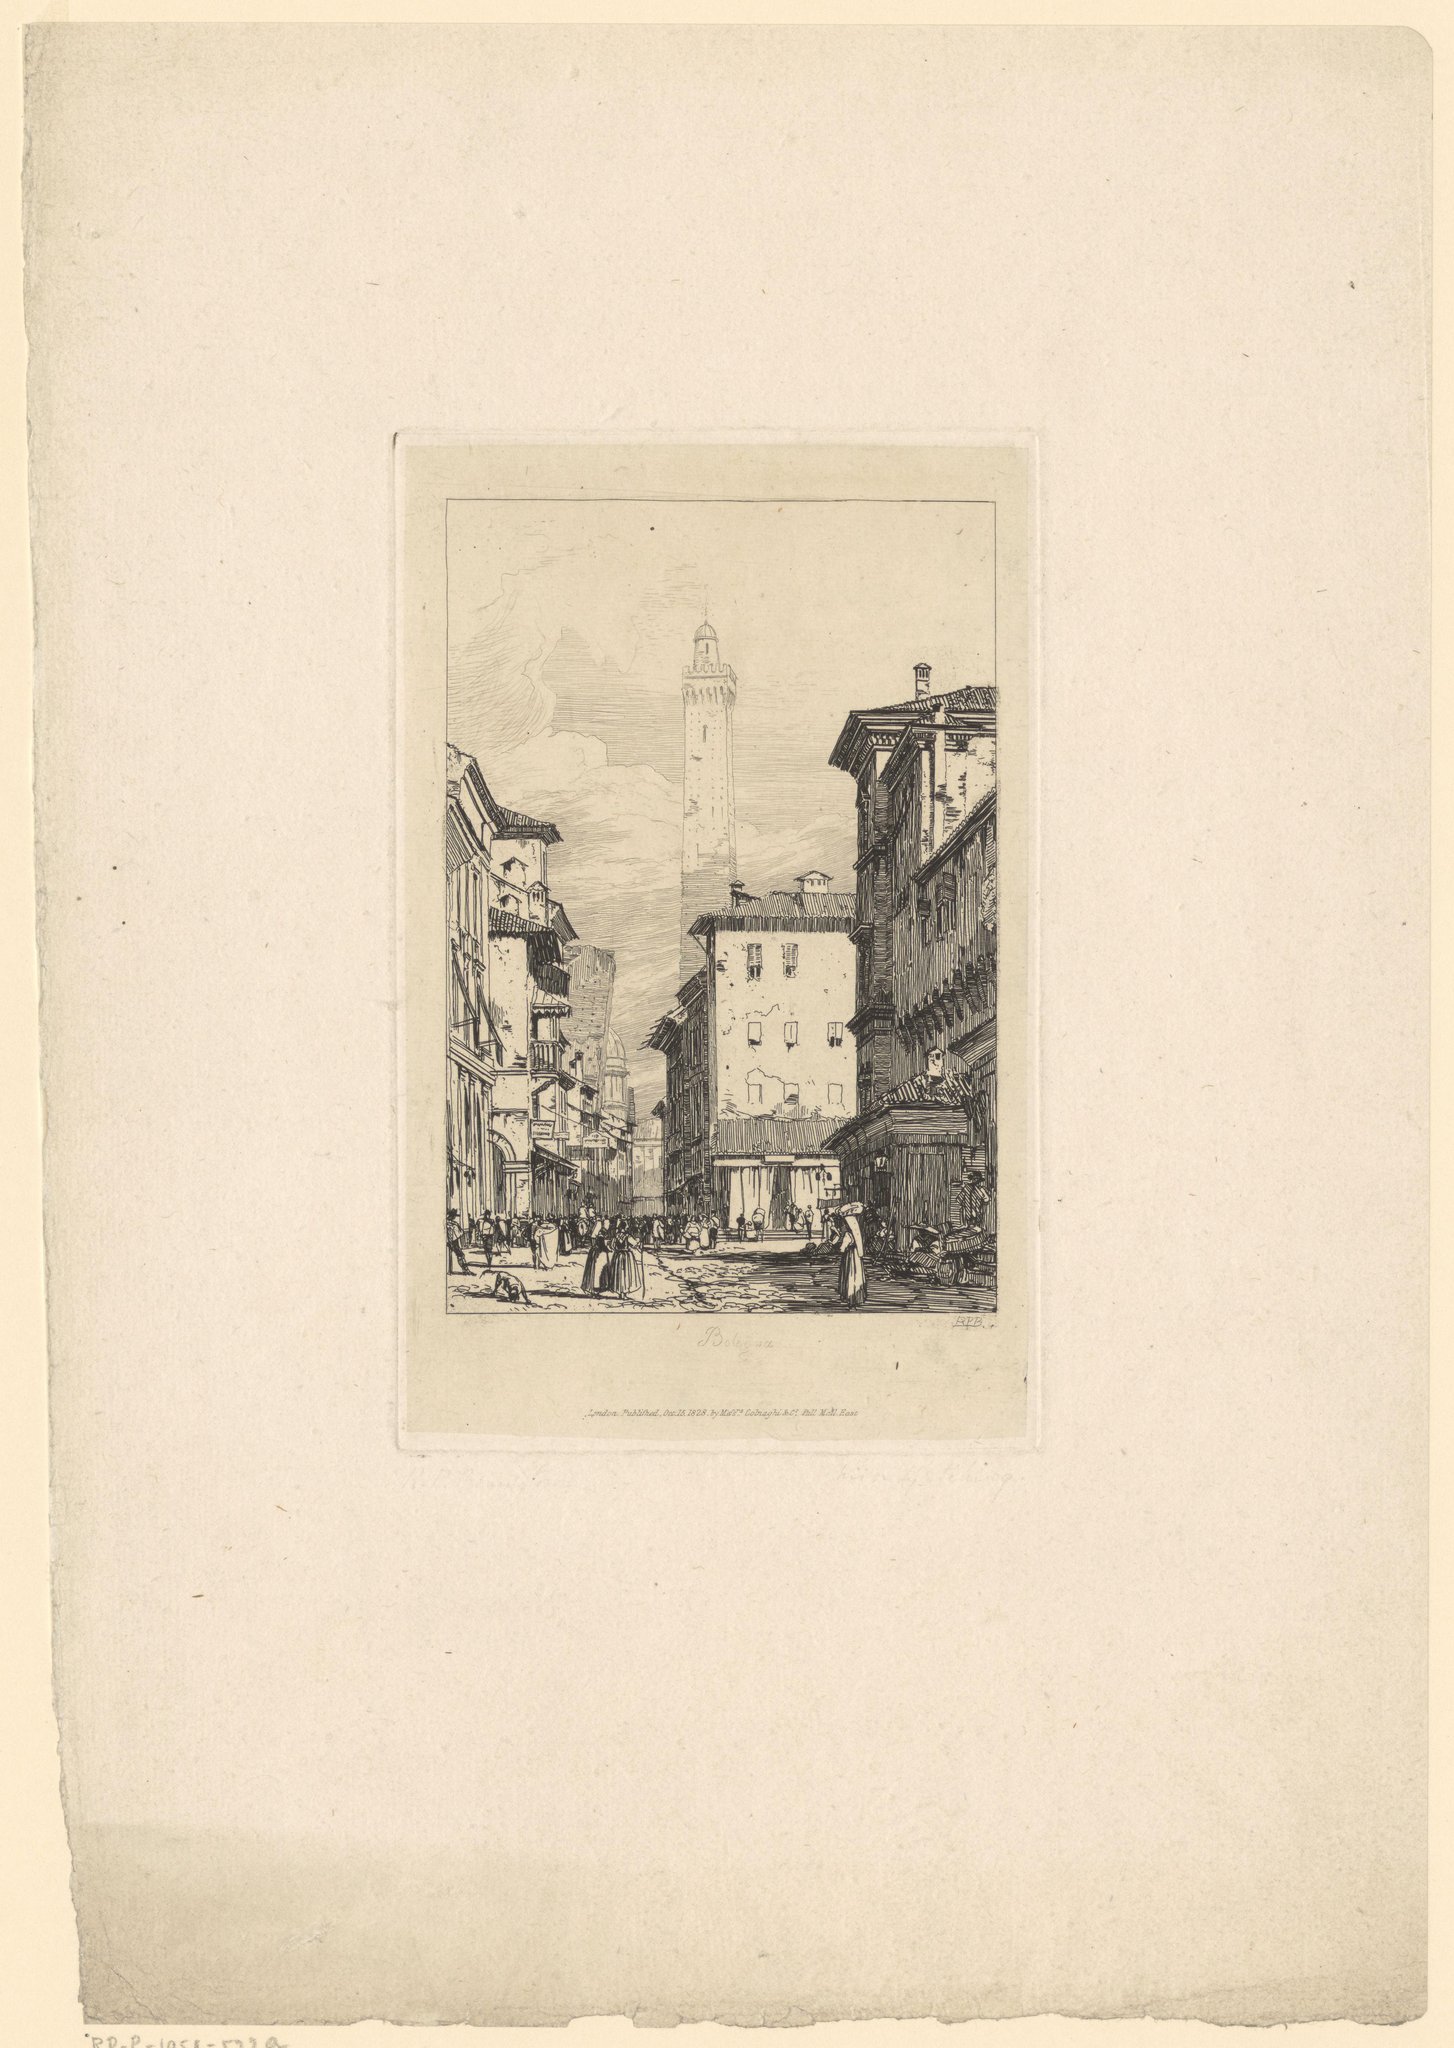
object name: print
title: Bologna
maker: richard parkes bonington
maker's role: painter, print maker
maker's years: 1801-1828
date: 1810-1828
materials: paper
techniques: etching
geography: london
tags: tower, clock tower ~ monumental adornment, street (+ city(-scape) with figures, staffage)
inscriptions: collector's mark: Lugt 2760, collector's mark: Lugt 2228